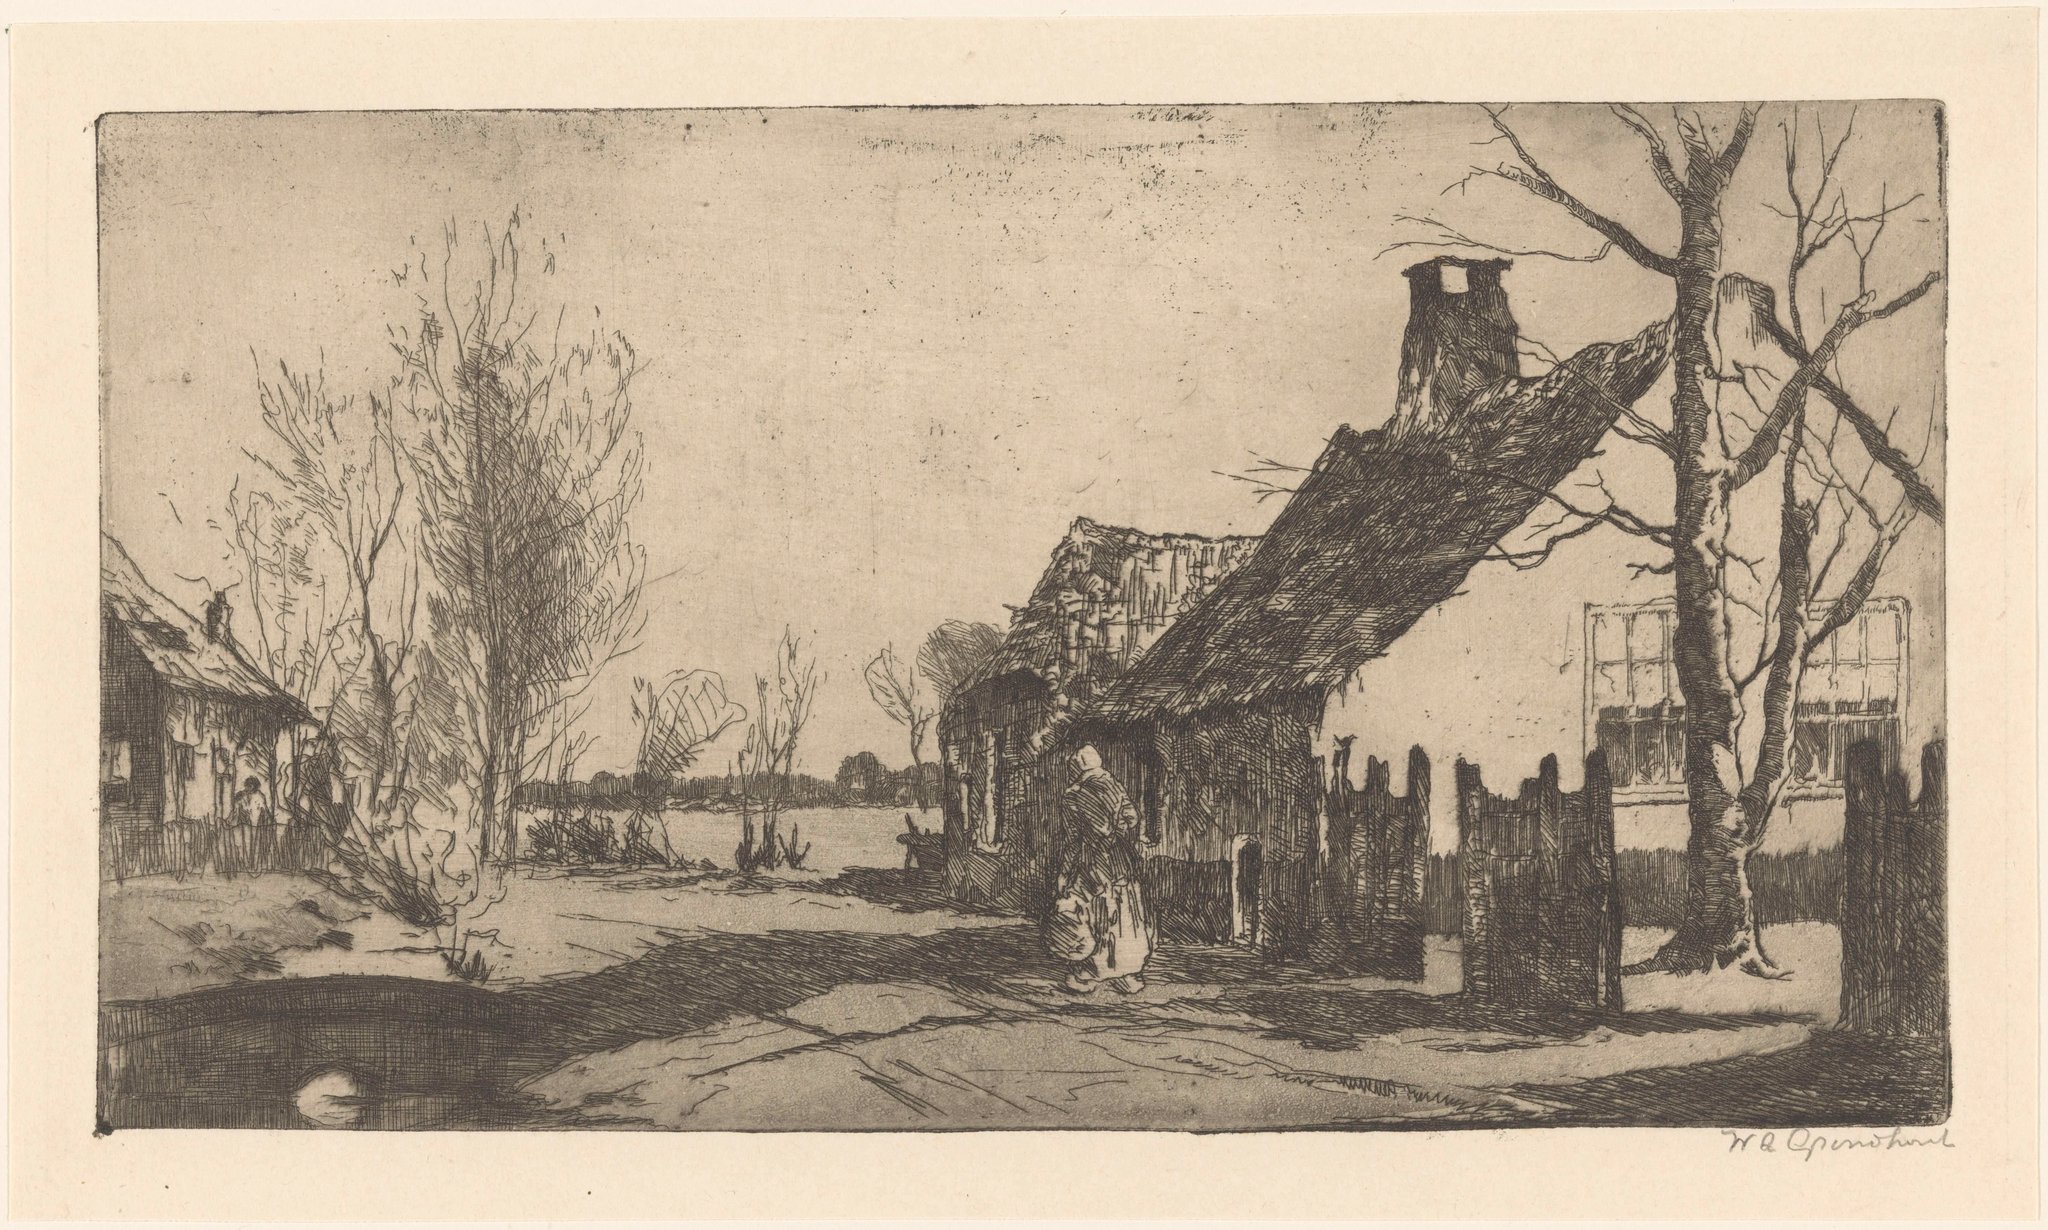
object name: print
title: Epe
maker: willem adrianus grondhout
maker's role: draughtsman, painter, print maker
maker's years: 1878-1934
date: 1888-1931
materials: paper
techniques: aquatint, etching, intaglio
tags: road, path, farm (building)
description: Een vrouw wandelt op een straat bij twee boerderijen.